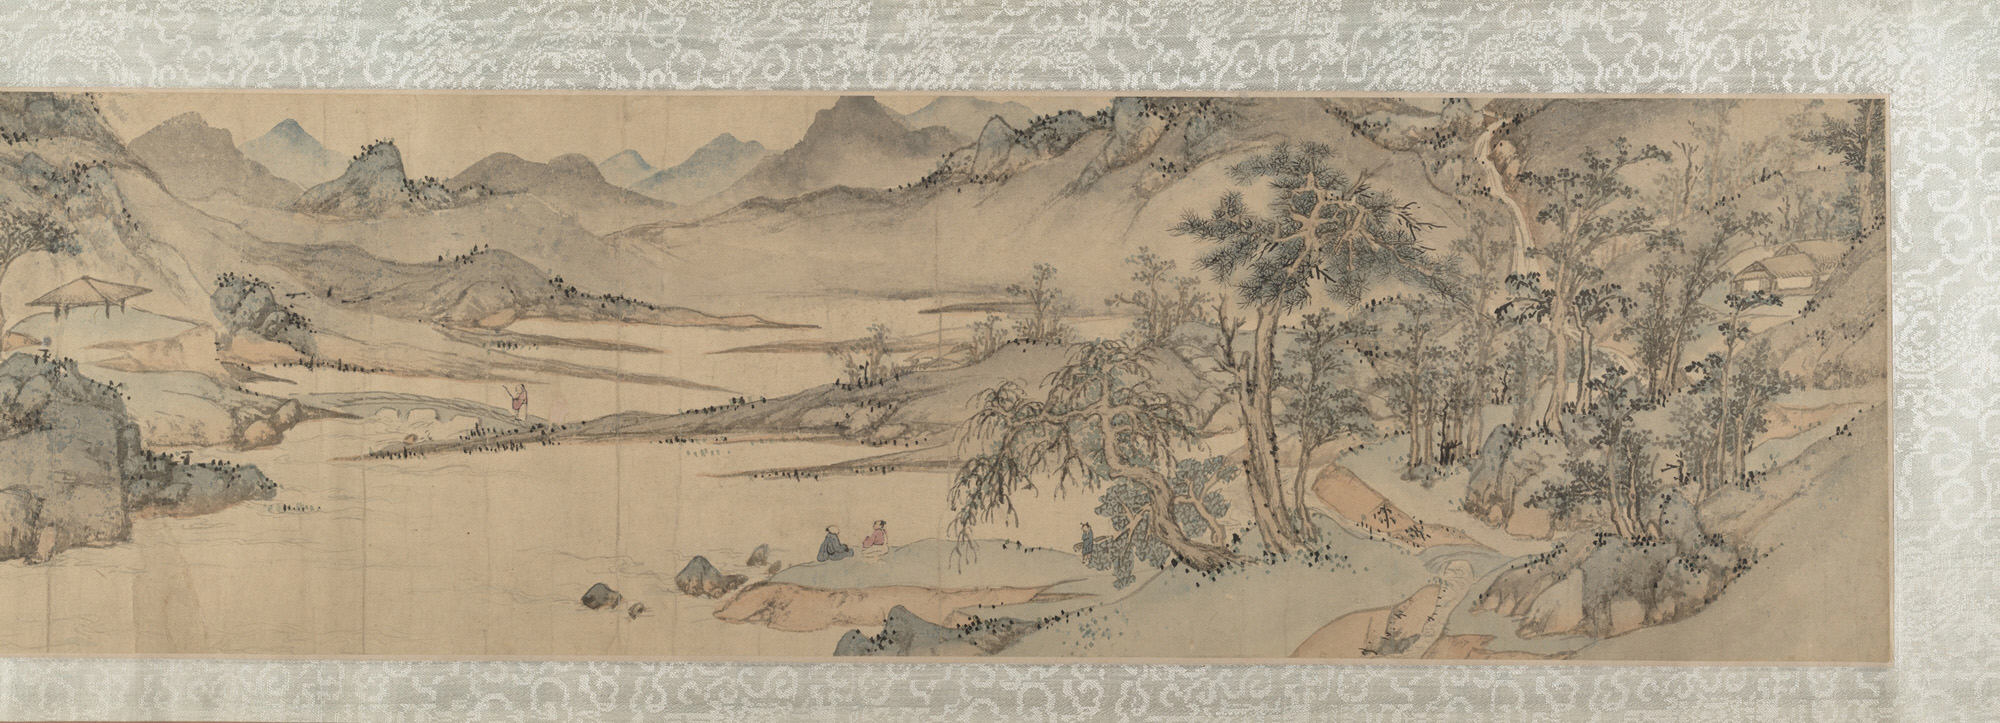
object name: handscroll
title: Landscape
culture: chinese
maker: wen boren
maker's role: artist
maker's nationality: chinese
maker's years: 1502-1575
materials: ink, paper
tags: mountains,landscapes